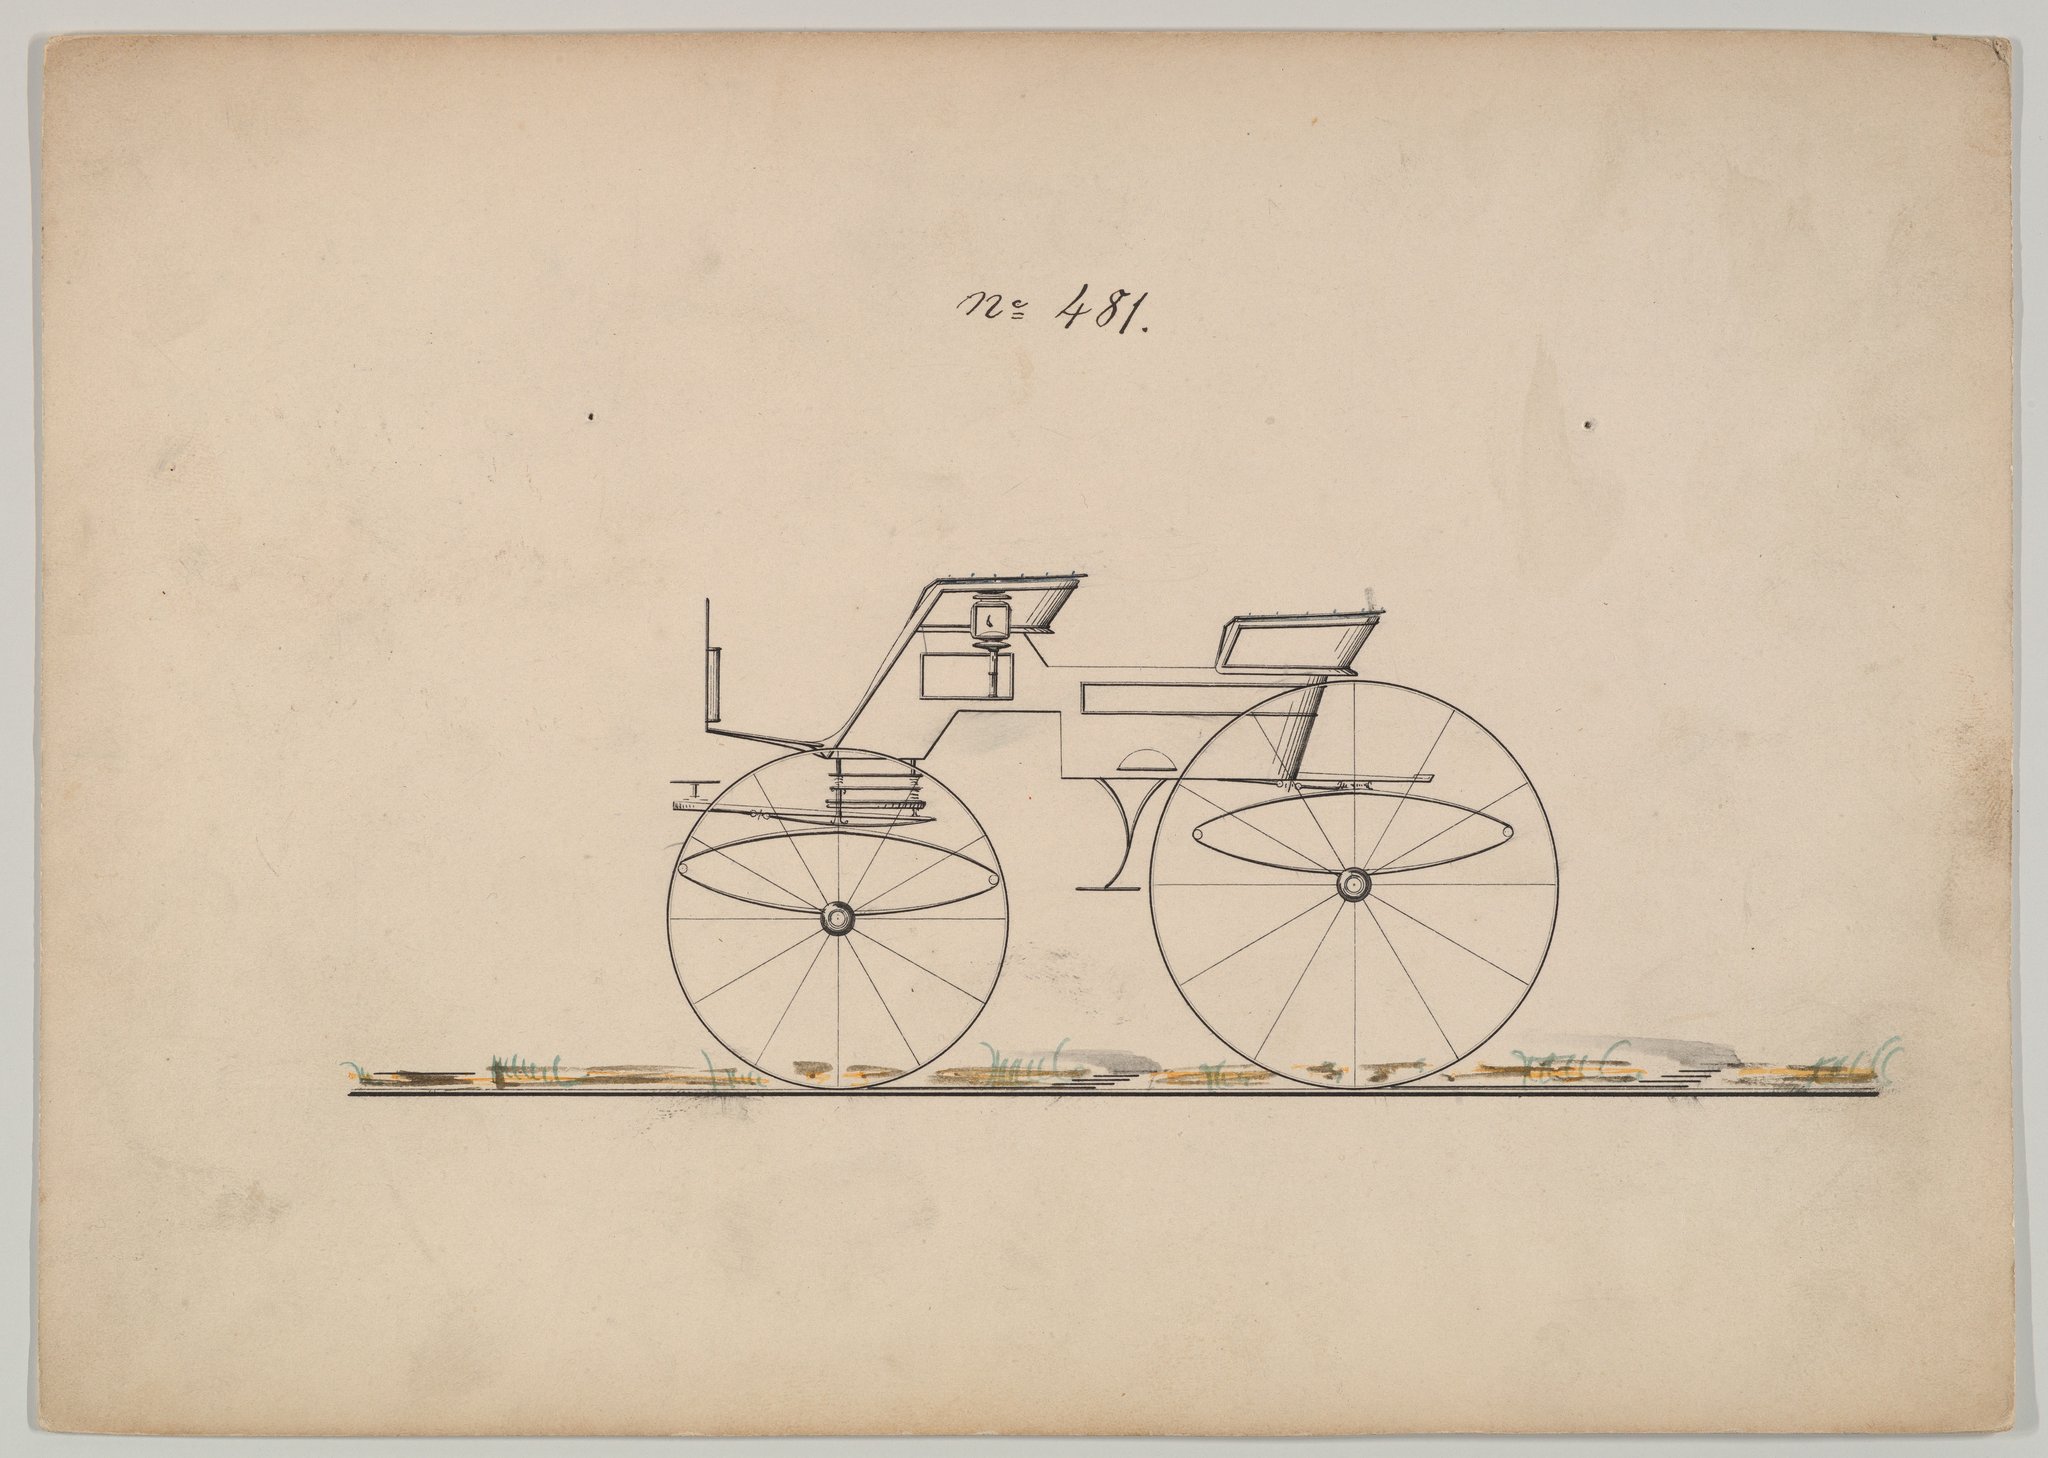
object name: drawing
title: Phaeton #481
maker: brewster & co.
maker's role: manufacturer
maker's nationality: american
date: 1850-1870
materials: gouache, ink, watercolor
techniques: pen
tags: carriages